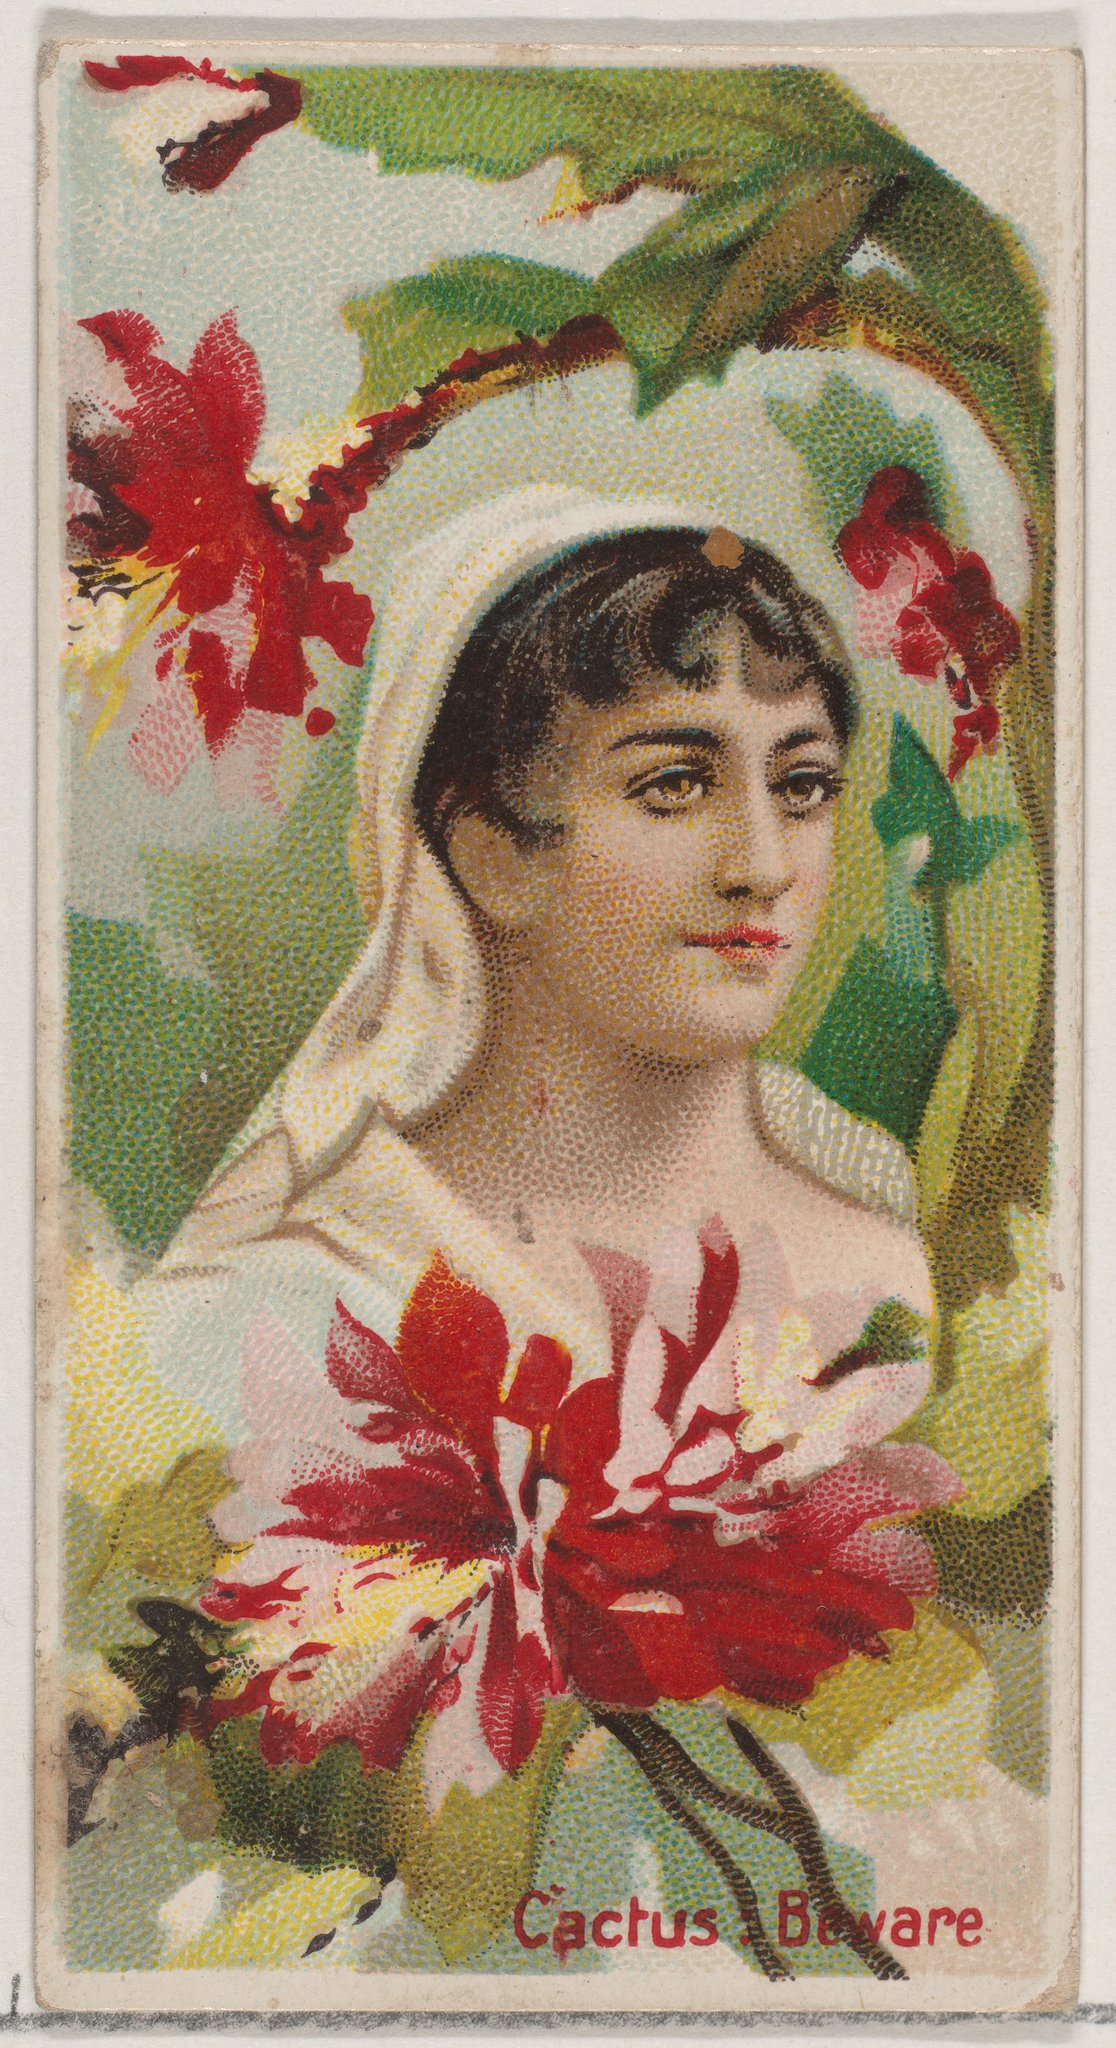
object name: print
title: Cactus: Beware, from the series Floral Beauties and Language of Flowers (N75) for Duke brand cigarettes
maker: american tobacco company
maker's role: publisher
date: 1892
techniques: color lithograph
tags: women,flowers